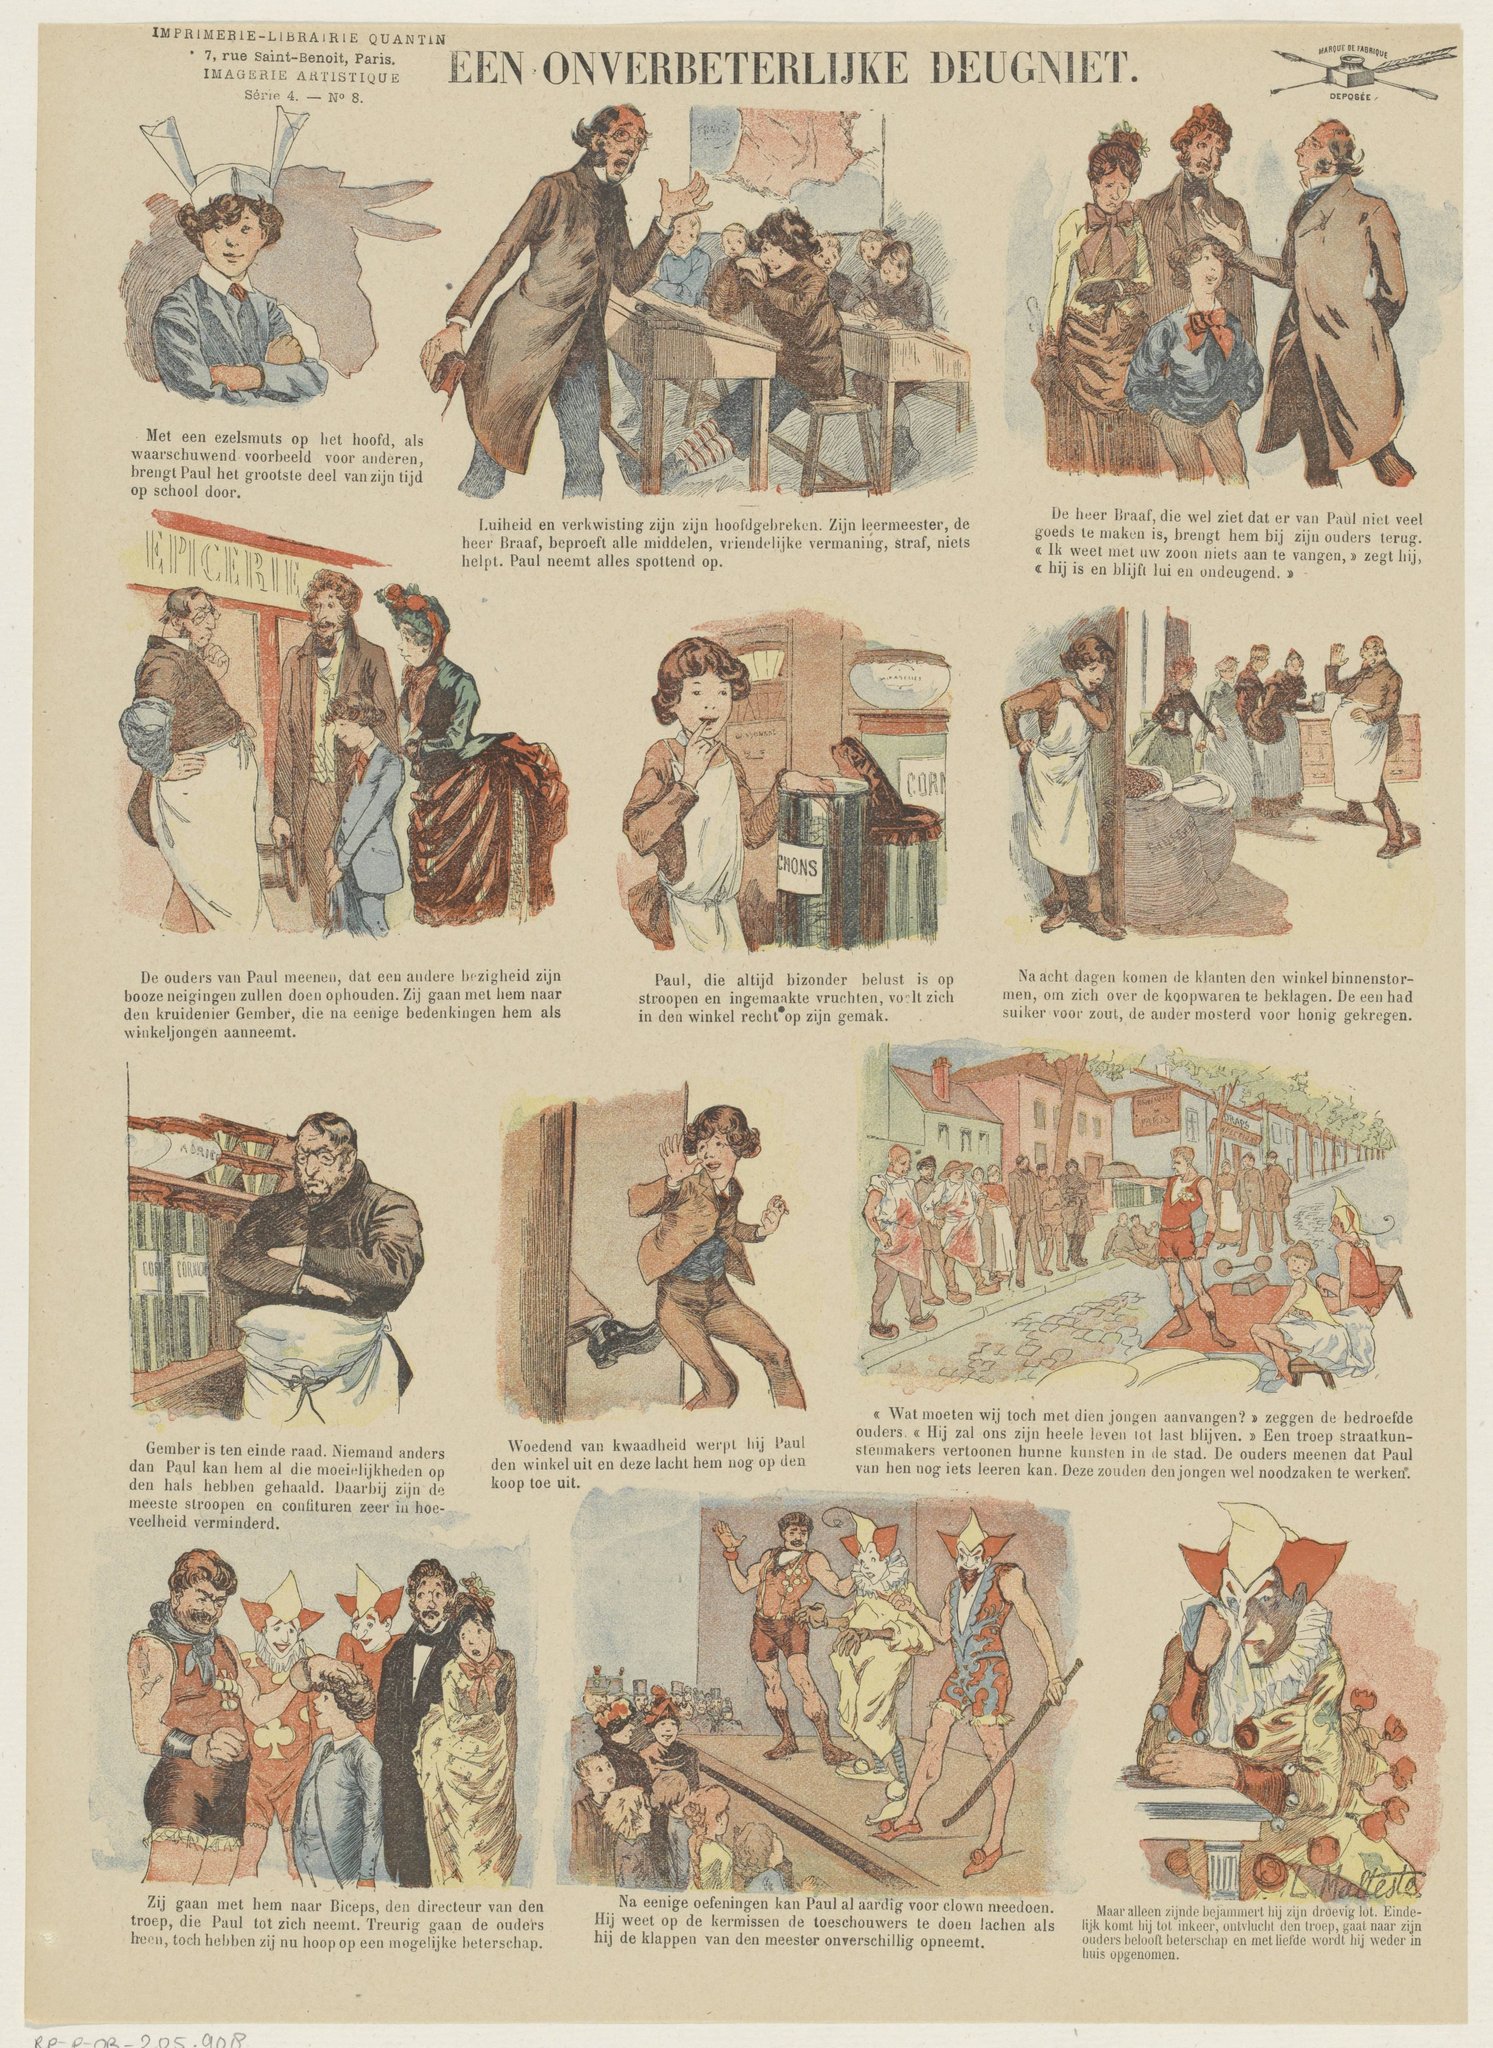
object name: popular print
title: Een onverbeterlijke deugniet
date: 1876-1890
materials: paper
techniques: lithograph, letterpress printing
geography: paris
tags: mischief-making play, bad behaviour, tales and fairy tales, clown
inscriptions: : ‘marque de fabrique / deposée’, collector's mark: Lugt 2760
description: Blad met 12 voorstellingen van de deugniet Paul die streken uithaalt. Onder elke voorstelling een onderschrift. Genummerd linksboven: Série 4. - No. 8.